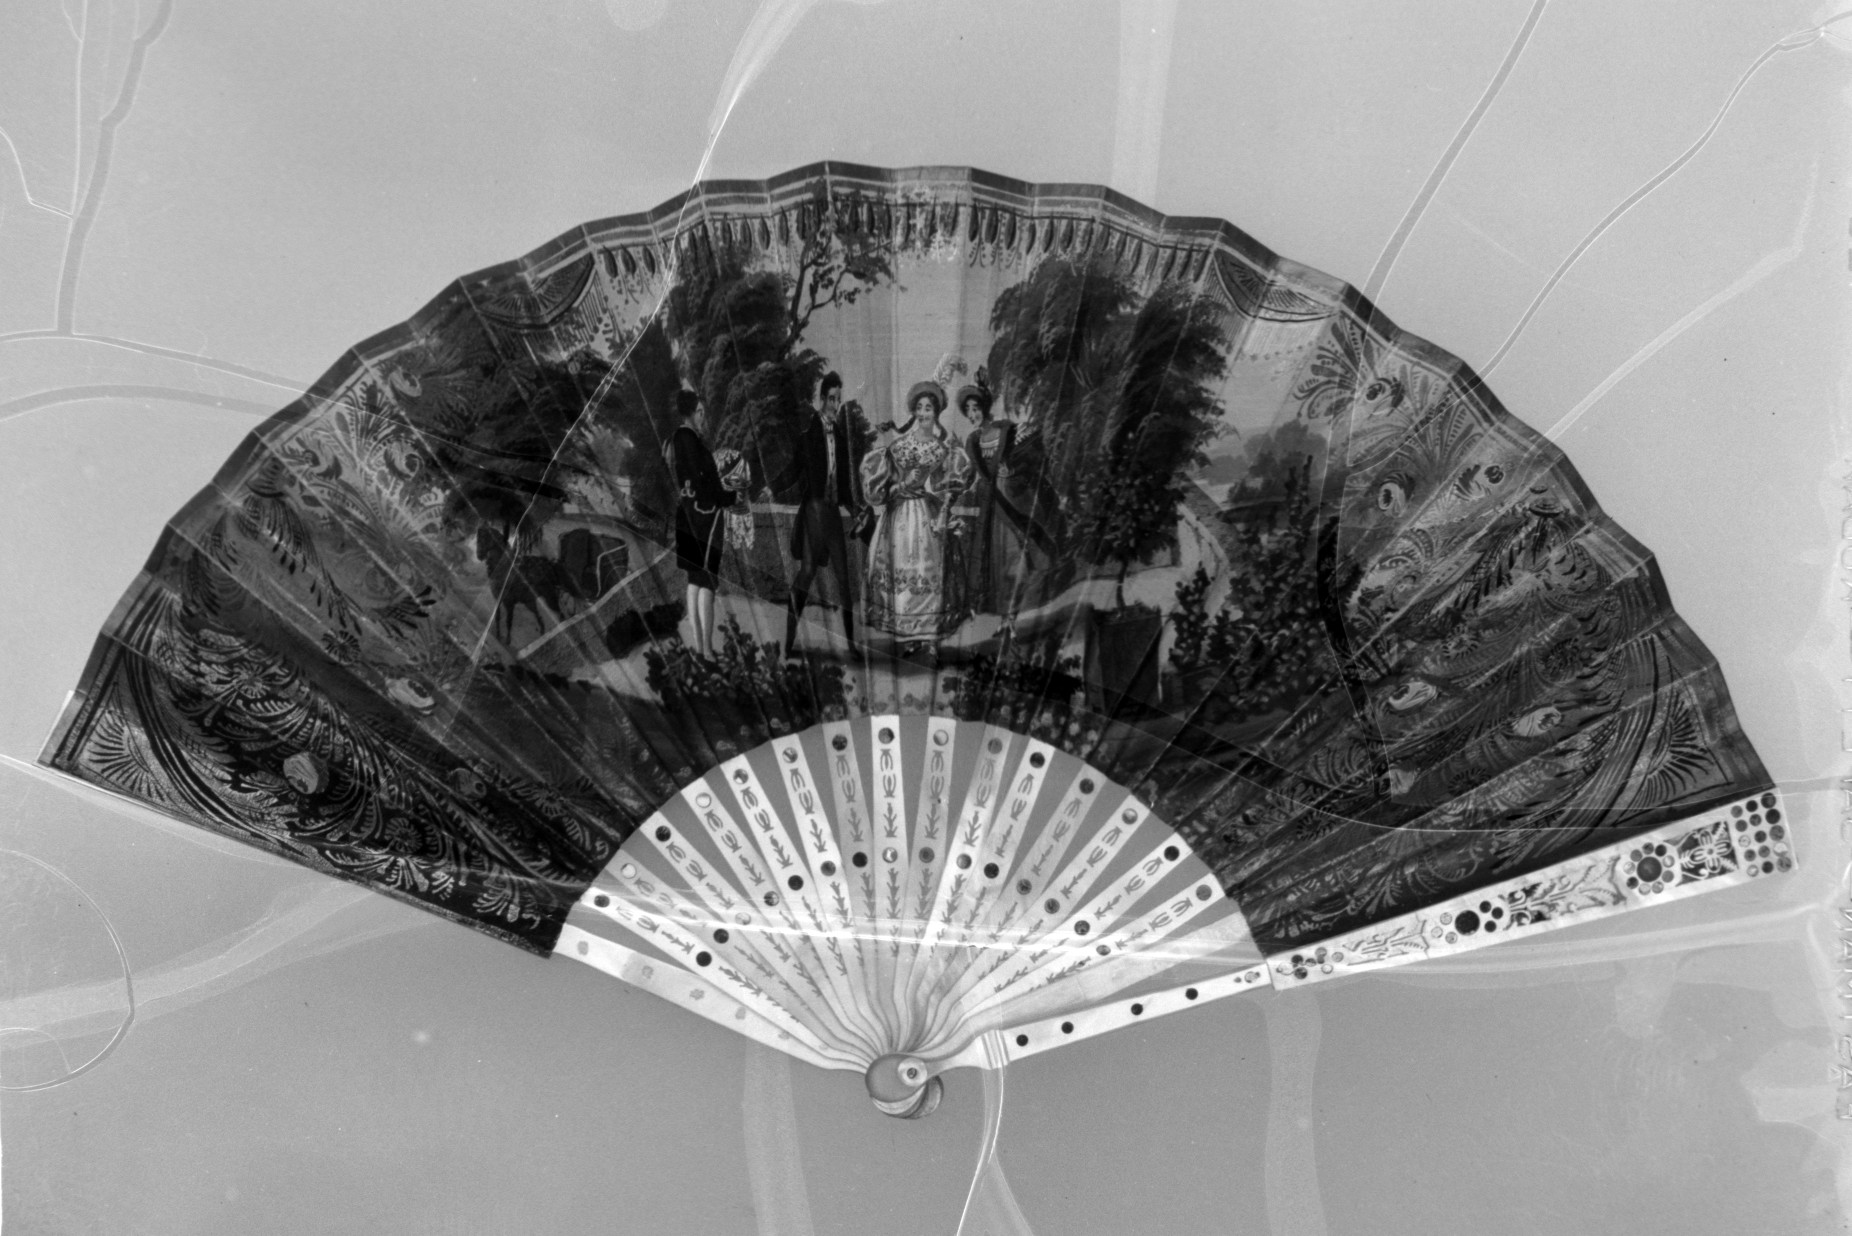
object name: fan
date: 1835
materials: lapis lazuli, mother of pearl, paper, silver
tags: men,women